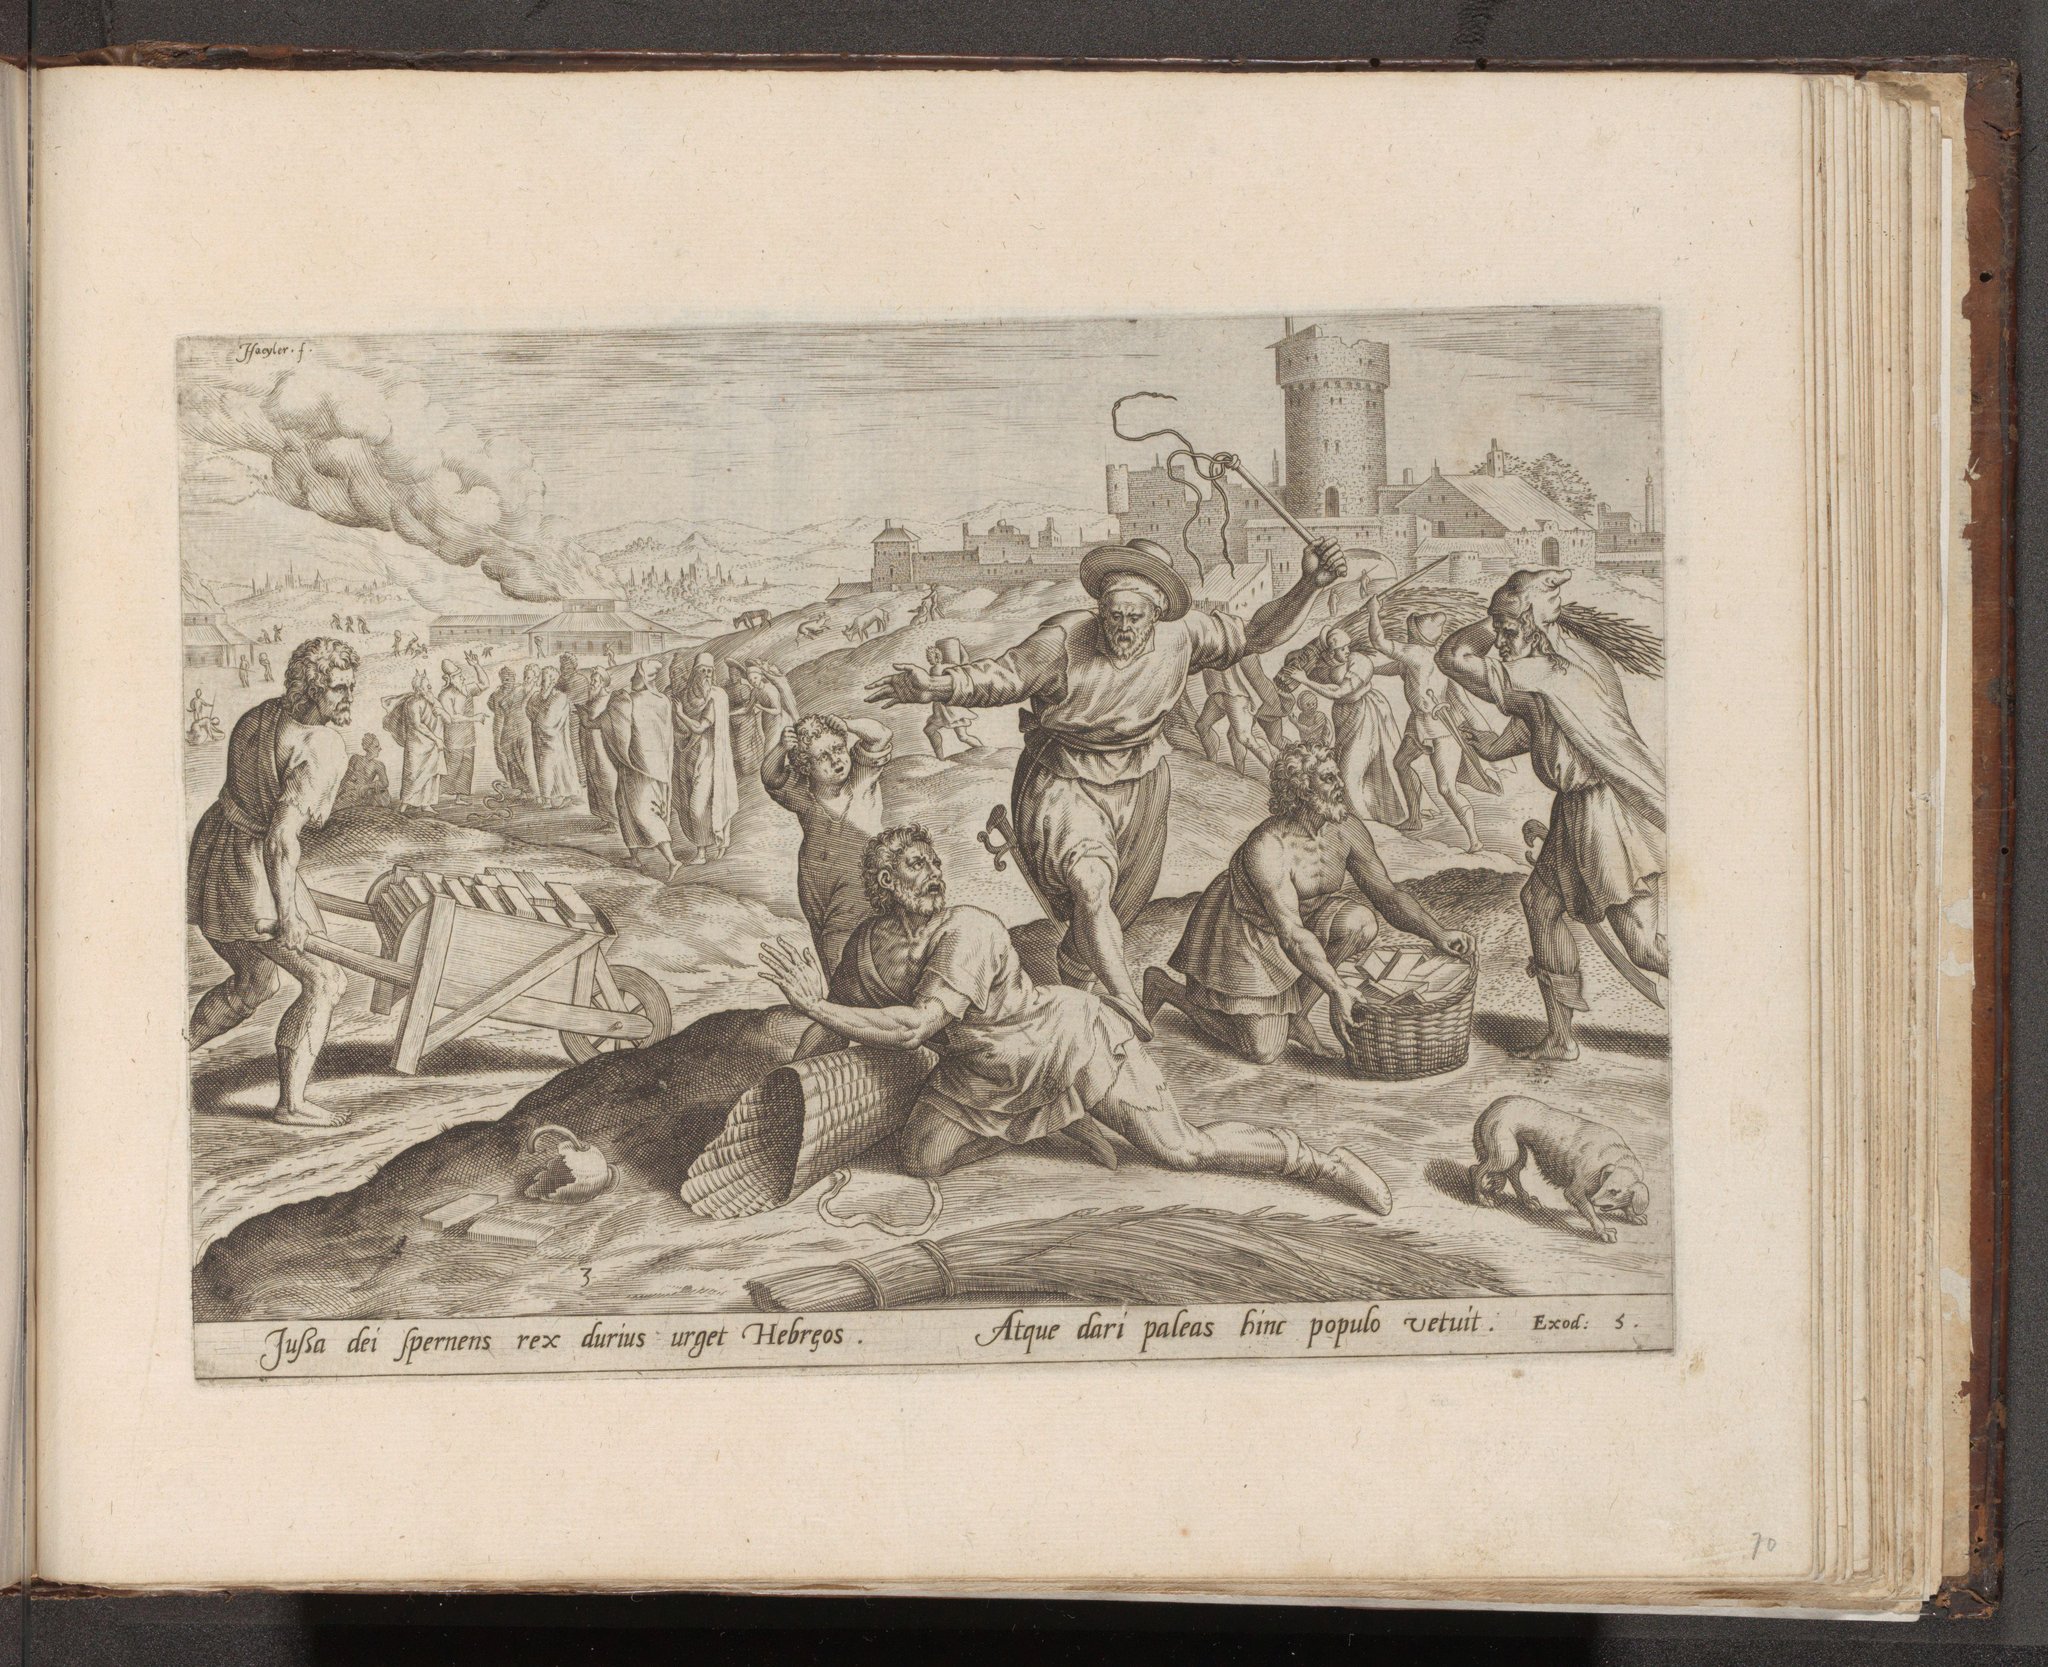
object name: print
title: Mishandeling van de Israëlieten door de Egyptenaren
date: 1579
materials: paper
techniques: engraving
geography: antwerp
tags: the israelites complain to moses and aaron (~ pharaoh), pharaoh commands the taskmasters to stop supplying the people with straw for making bricks (+ variant)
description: Een Israëlitische arbeider valt op de grond en wordt door een van de Egyptische opzichters van de farao met een zweep geslagen. De Israëlieten verzamelen stro voor het bakken van stenen. Op de achtergrond preken Mozes en Aäron. Onder de voorstelling een verwijzing in het Latijn naar de Bijbeltekst in Ex. 5. Prent maakt deel uit van een album.